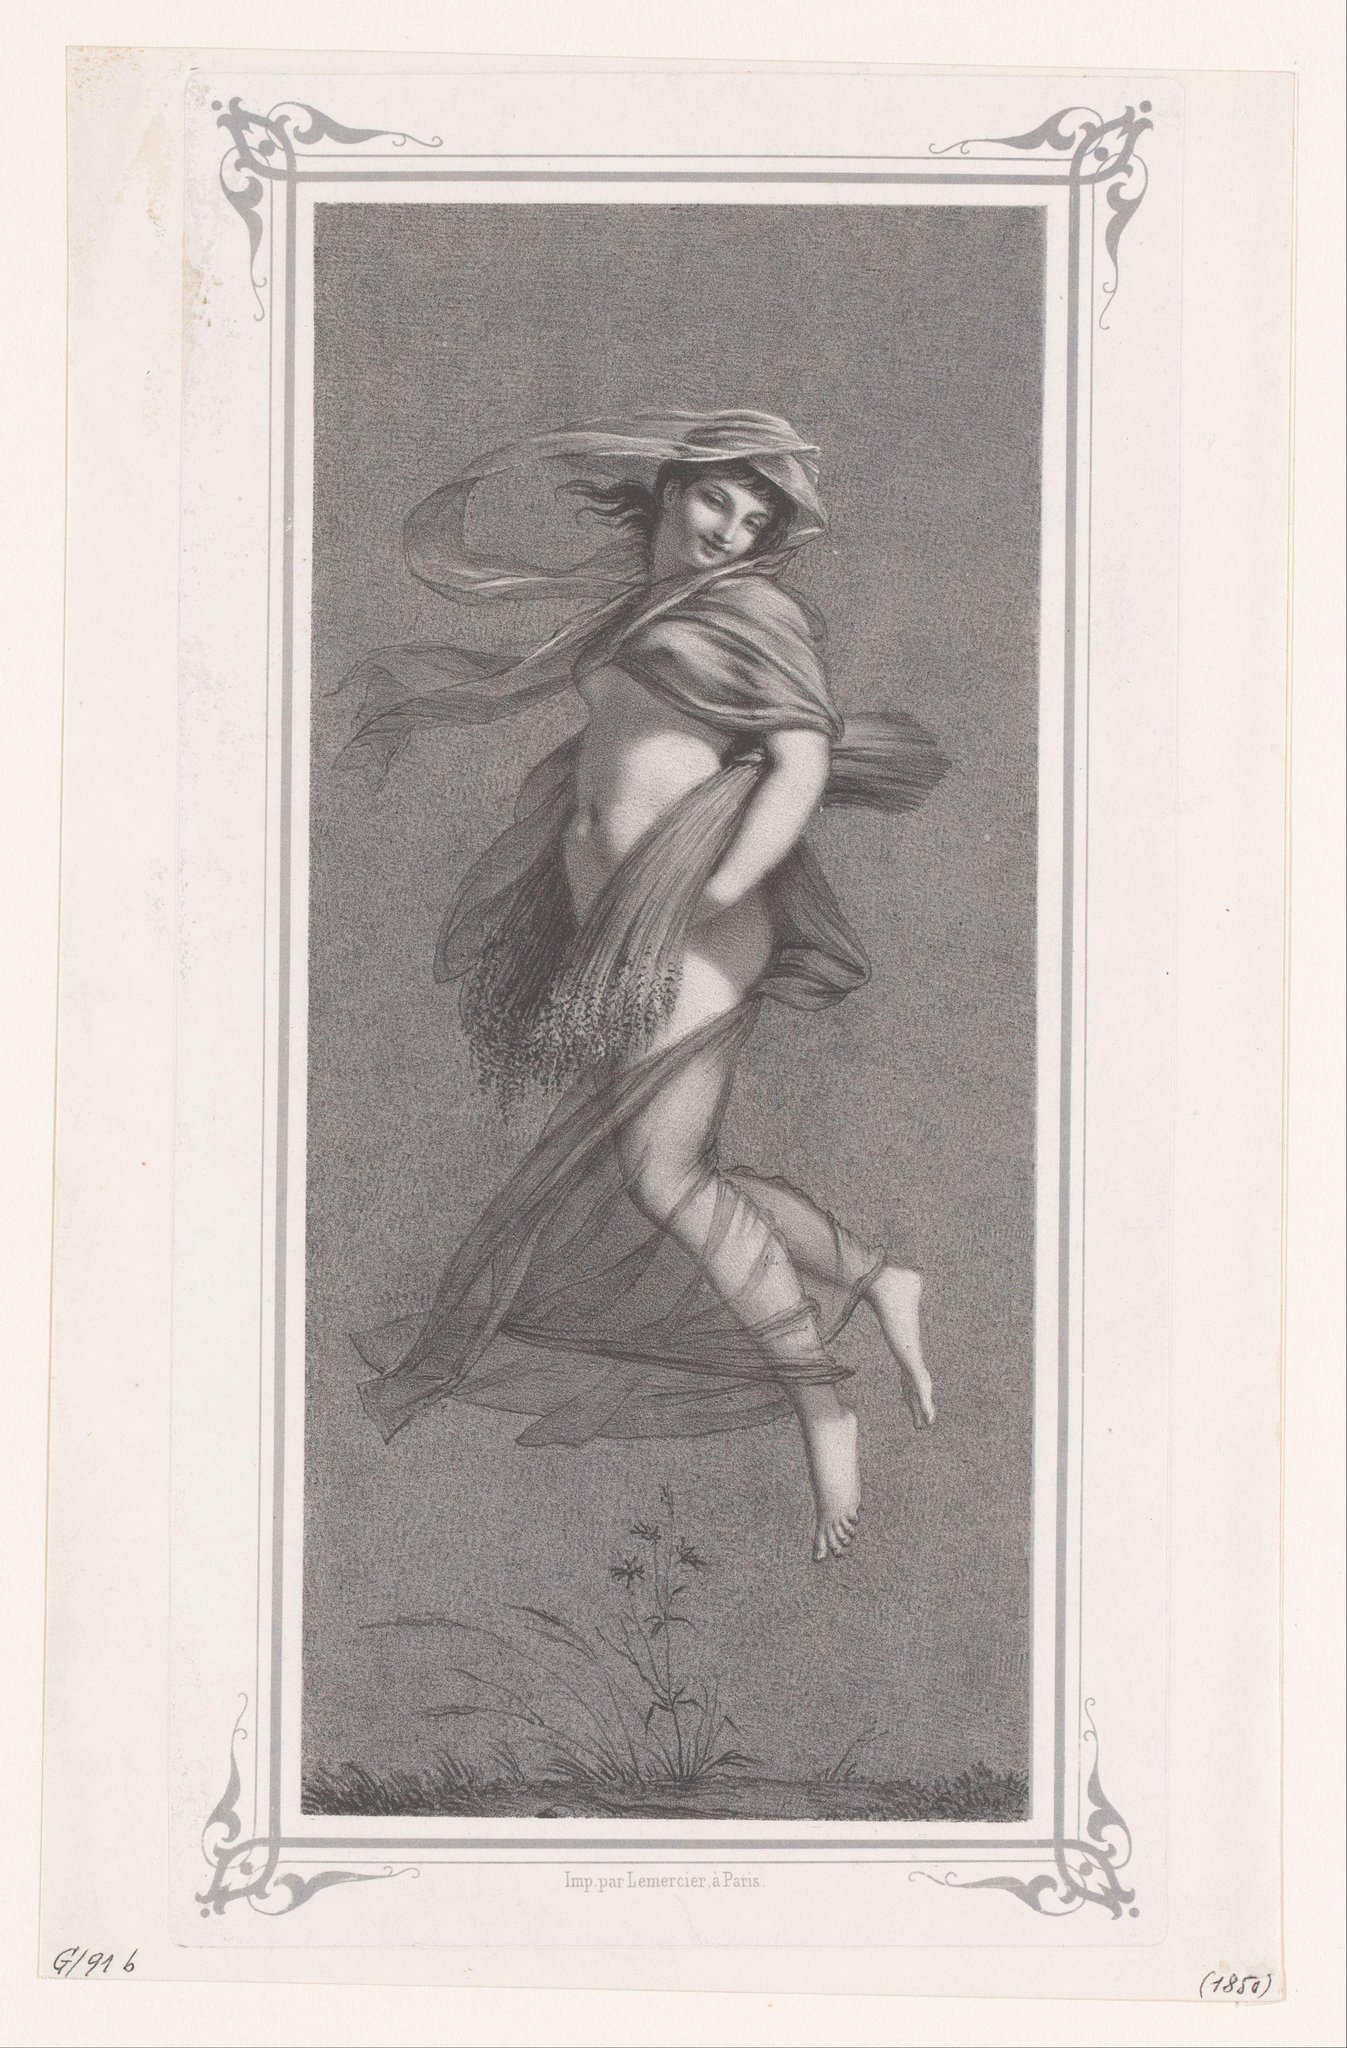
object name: print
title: Vier seizoenen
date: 1810-1880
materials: paper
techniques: tone lithography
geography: paris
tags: summer, 'aestas'; 'estate' (ripa)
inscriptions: collector's mark: Lugt 2760, collector's mark: Lugt 2228